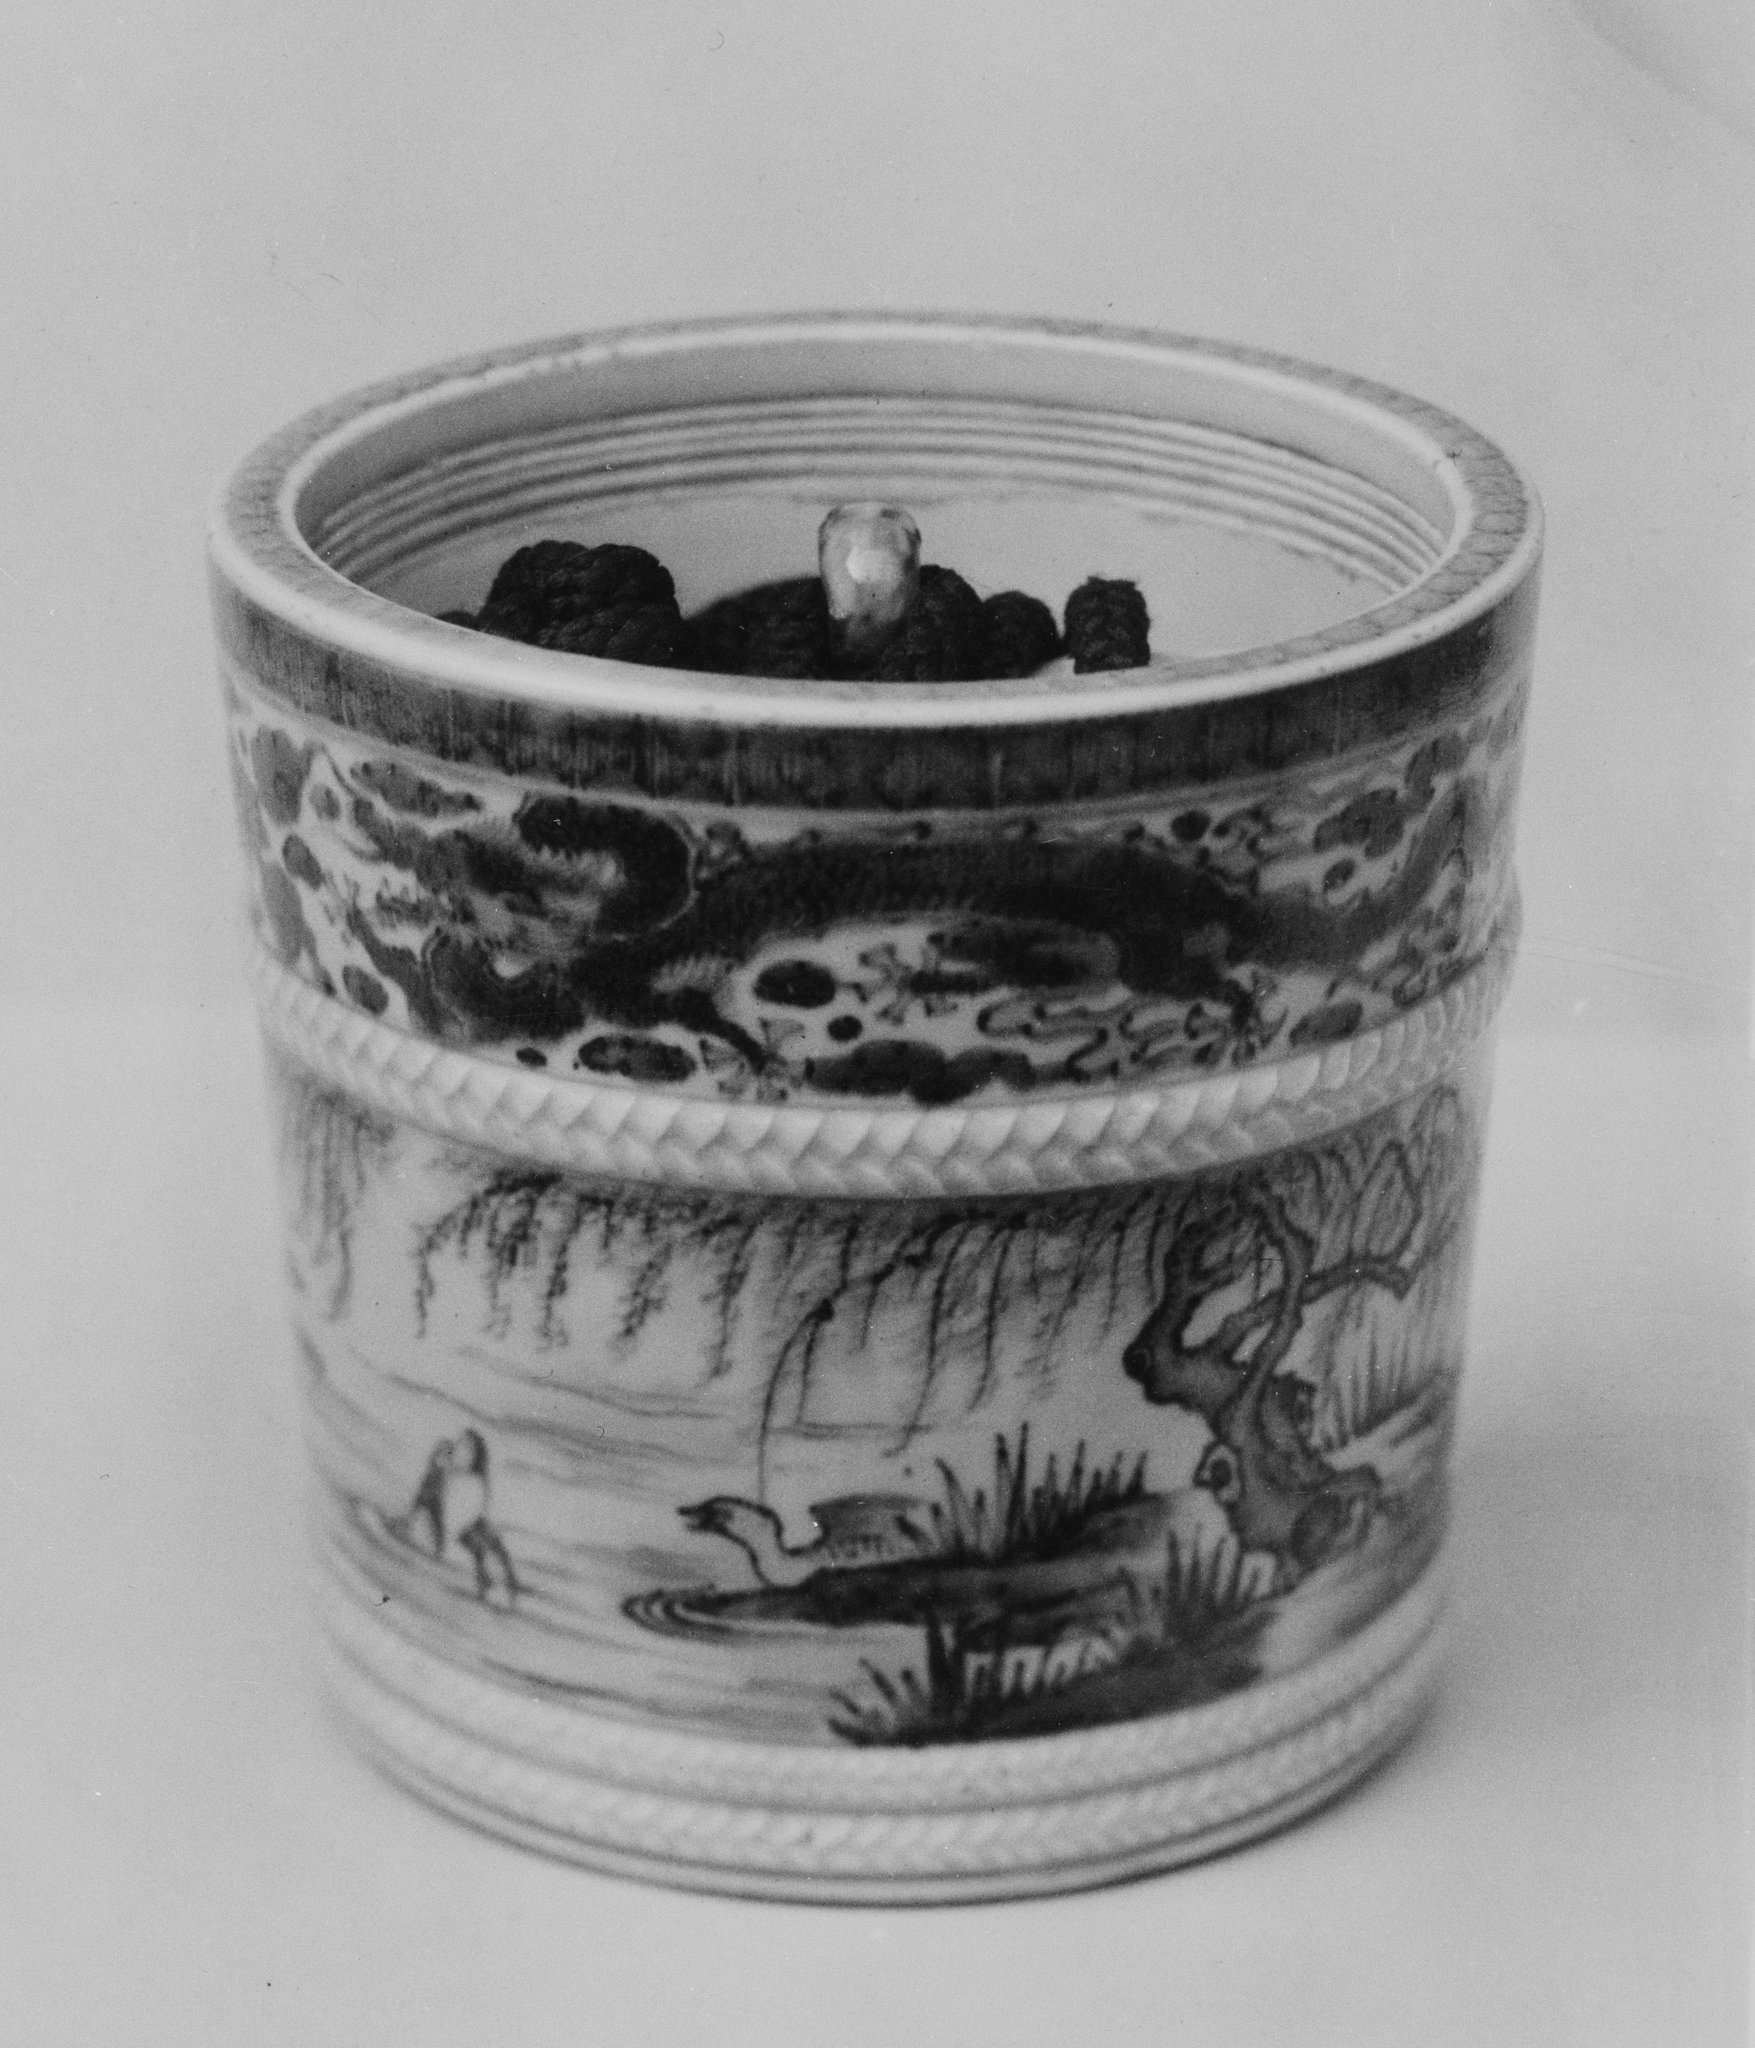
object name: bucket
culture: japanese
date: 1840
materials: porcelain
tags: birds,dragons,trees